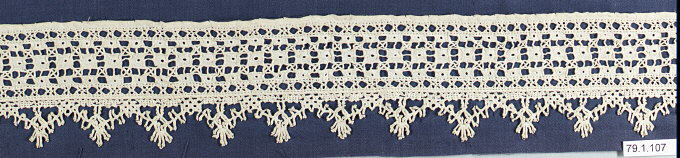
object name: strip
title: Strip with corner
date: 1600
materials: linen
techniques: embroidery